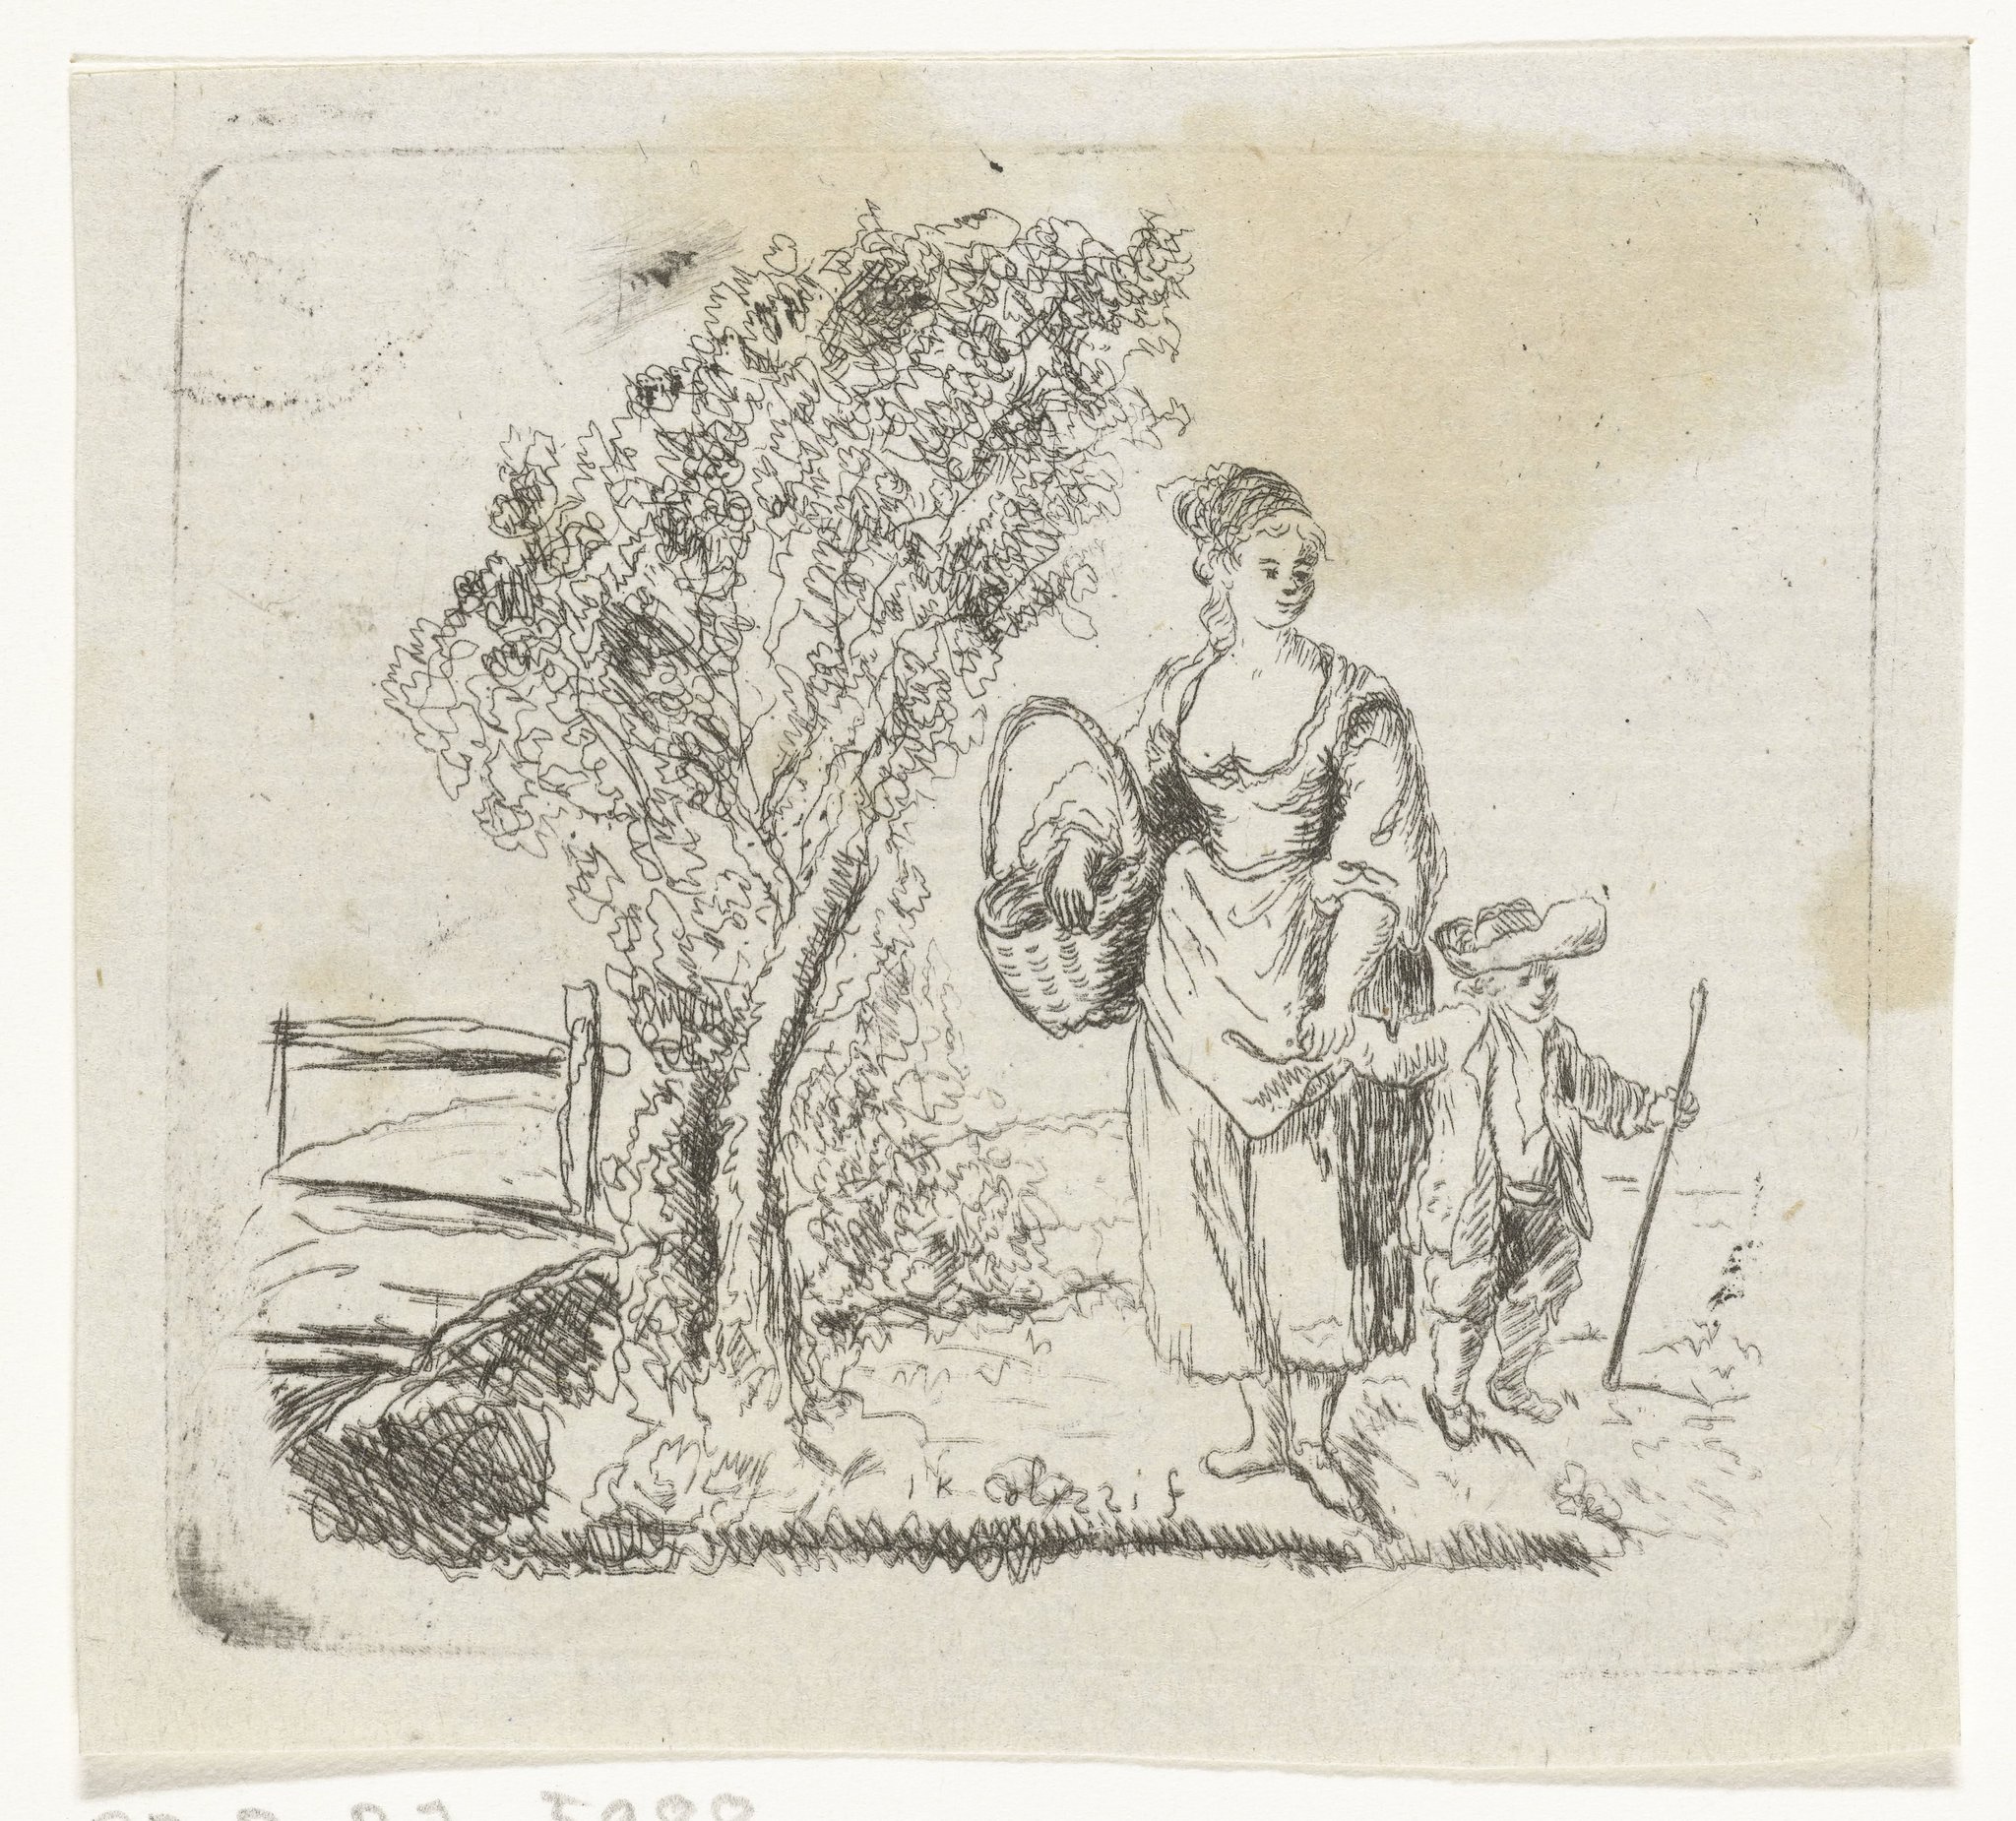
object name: print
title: Moeder met kind in landschap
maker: johan antoni kauclitz colizzi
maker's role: print maker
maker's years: 1742-1808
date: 1774-1808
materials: paper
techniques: etching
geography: netherlands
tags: mother and son(s) (family group)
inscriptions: collector's mark: Lugt 2228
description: Een moeder is met haar zoon aan het wandelen. De zoon heeft een wandelstok de moeder draagt een mand.